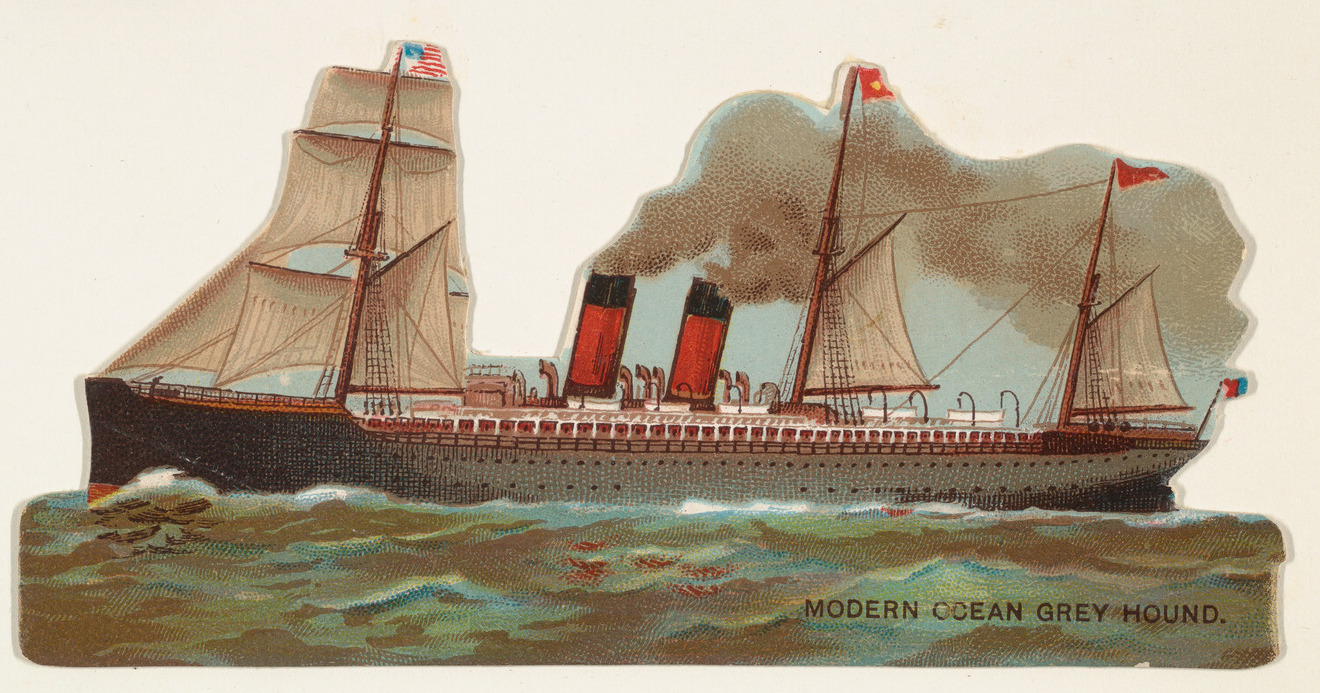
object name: print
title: Modern Ocean Grey Hound, from the Types of Vessels series (N139) issued by Duke Sons & Co. to promote Honest Long Cut Tobacco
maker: w. duke, sons & co.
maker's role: publisher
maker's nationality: american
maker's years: 1870-1920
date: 1889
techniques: color lithograph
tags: ships